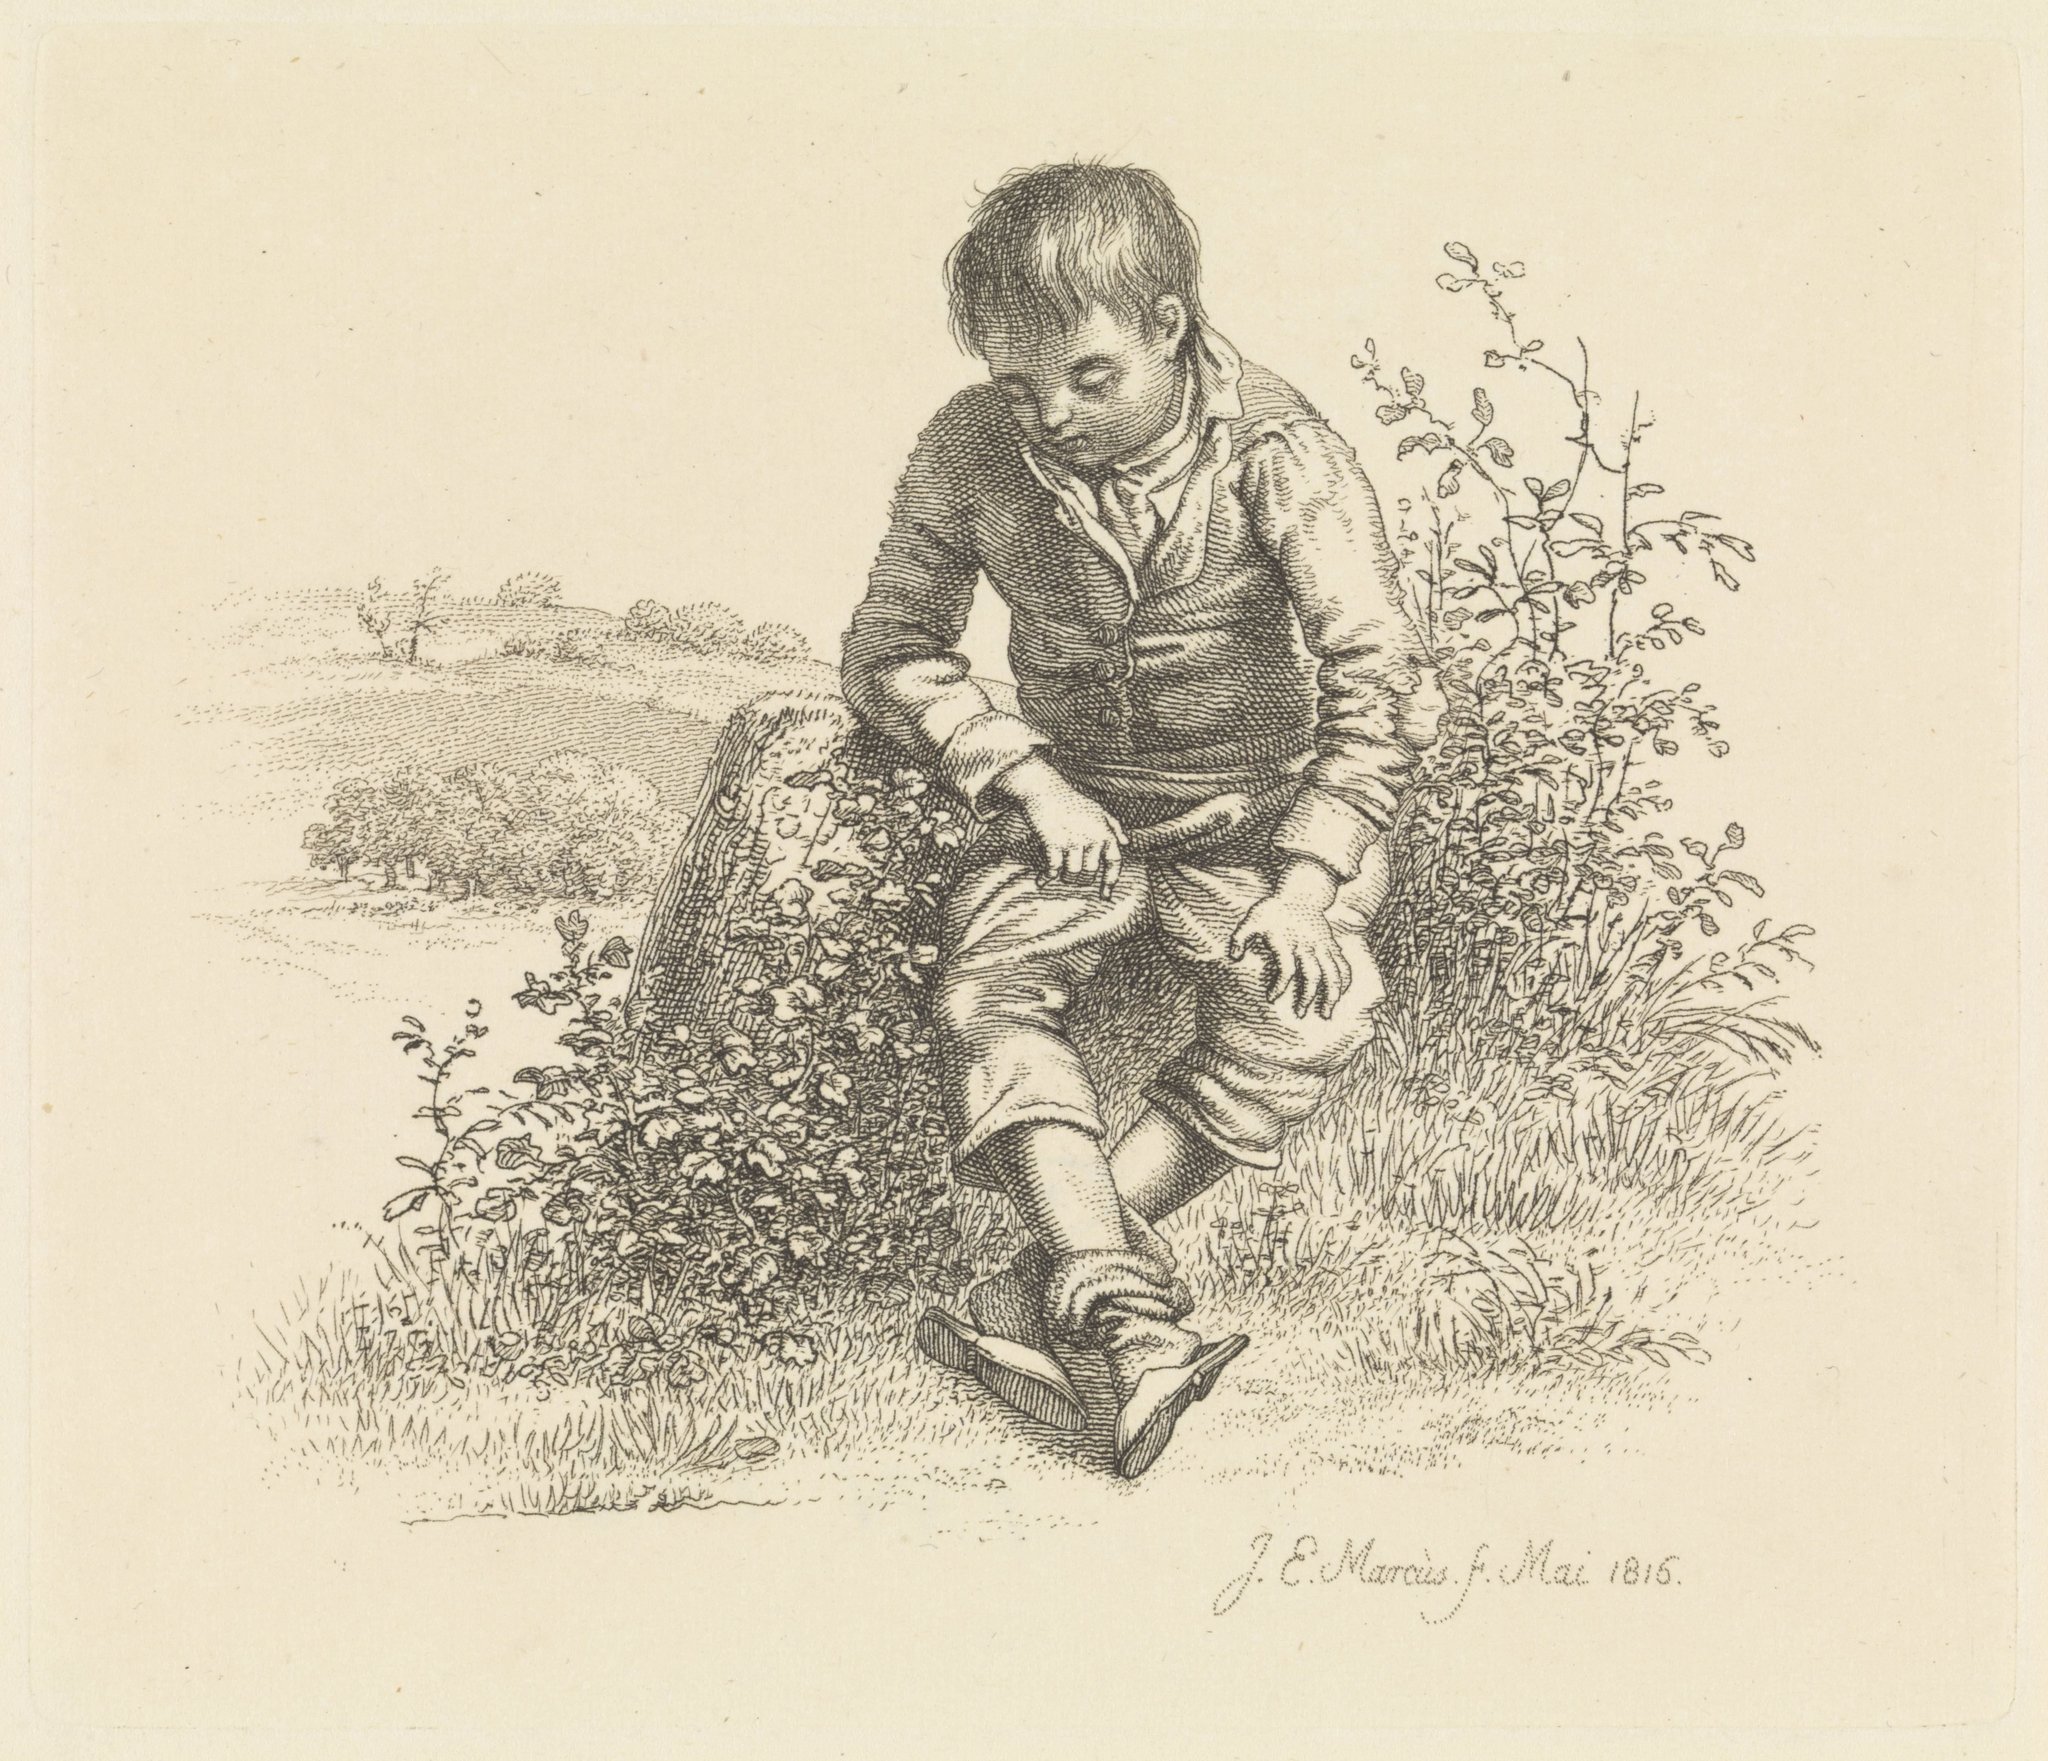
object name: print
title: Zittende jongen in een landschap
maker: jacob ernst marcus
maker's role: draughtsman, print maker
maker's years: 1774-1826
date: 1805-1816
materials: paper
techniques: etching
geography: amsterdam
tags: child (+ sitting)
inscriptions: collector's mark: Lugt 2228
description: Serie voor het eerst uitgegeven door Jacob Ernst Marcus onder de titel Studiebeelden en Fragmenten. Amsterdam: ca.1816. Later heruitgegeven als: Studie-prentwerk/ Etudes gravées.